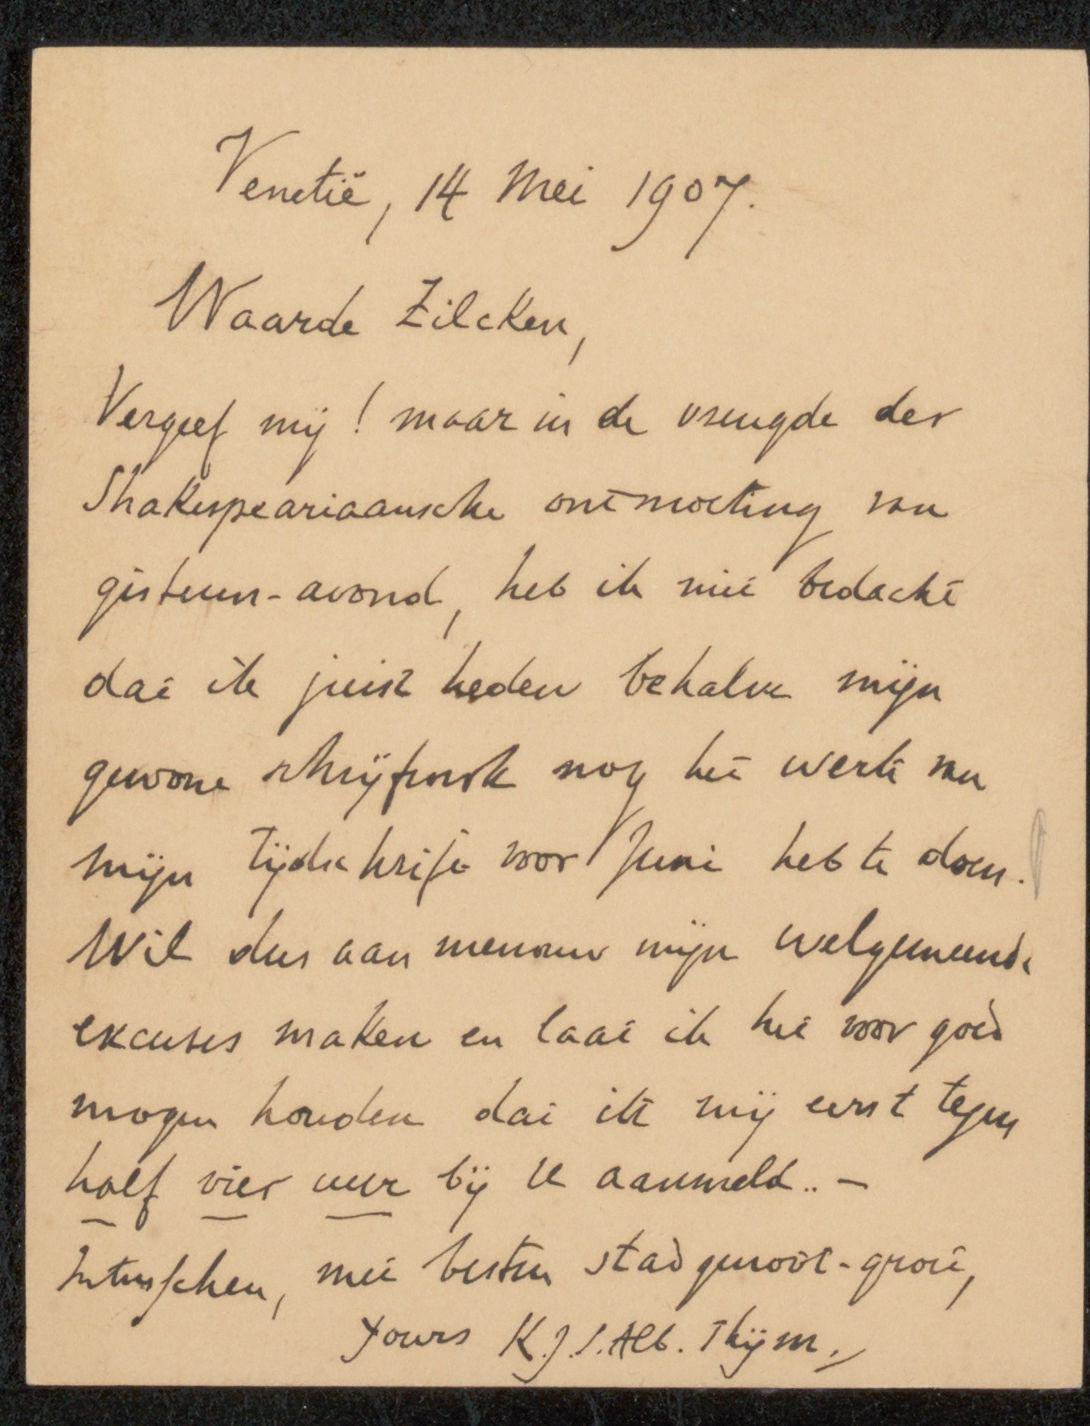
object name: letter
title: Brief aan Philip Zilcken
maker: karel johan lodewijk alberdingk thijm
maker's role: criticus, prozaschrijver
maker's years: 1864-1952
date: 1907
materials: cardboard, ink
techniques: pen, printing, writing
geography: venice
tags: the hague, draughtsman, philip zilcken, printed matter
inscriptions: collector's mark: ‘RPK’